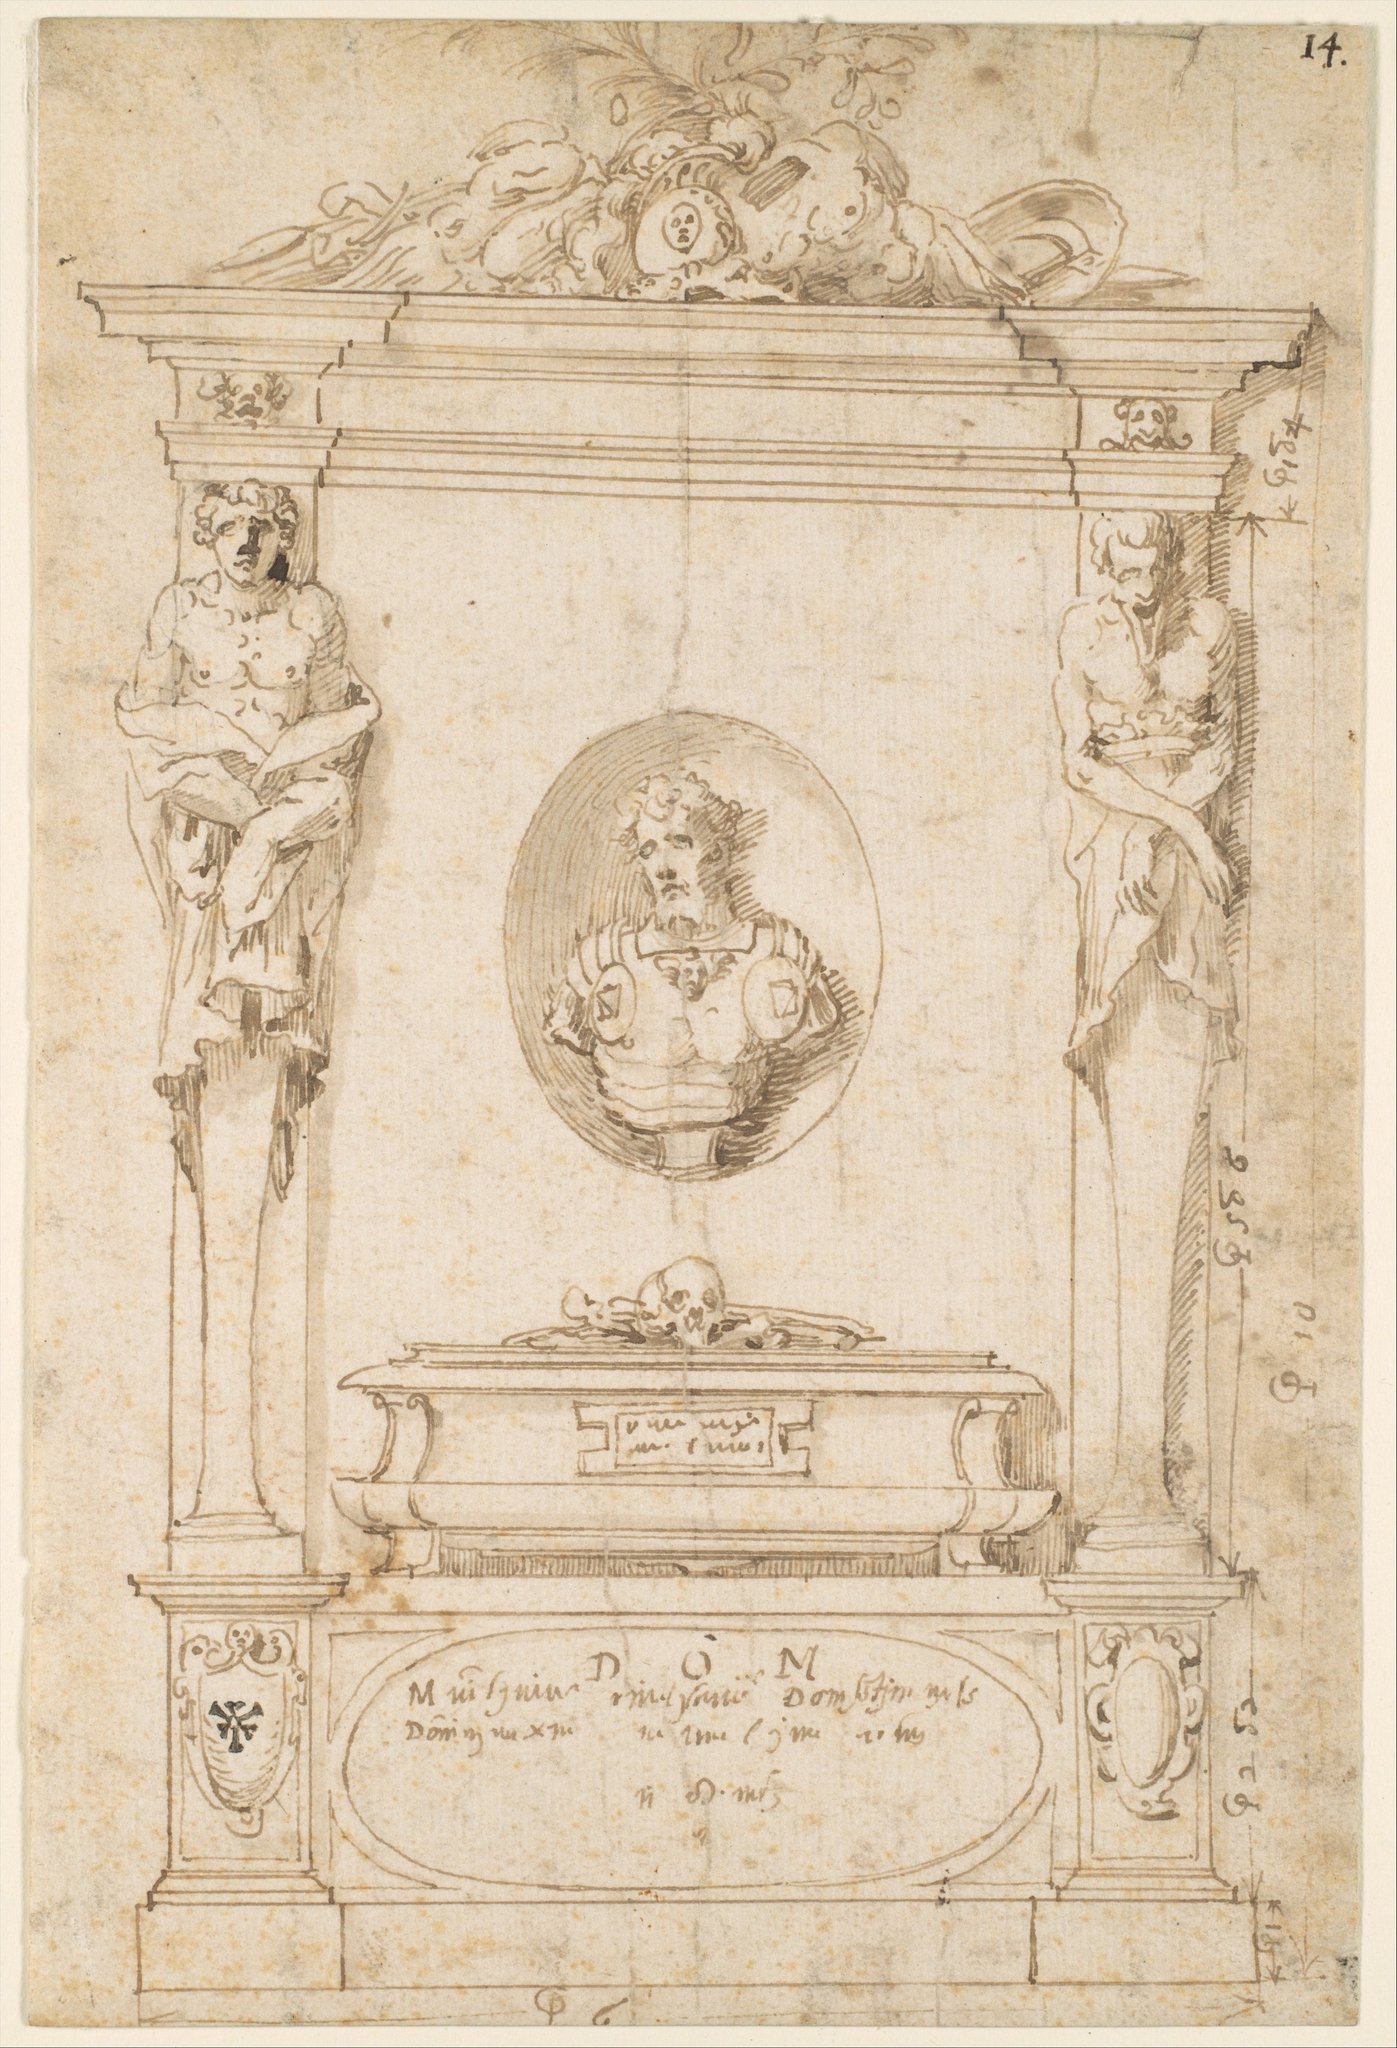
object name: drawing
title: Design for a Tomb with Herms and a Niche with a Bust Portrait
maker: anonymous, italian, 16th century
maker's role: artist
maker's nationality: italian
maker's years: 1550-1600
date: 1501-1600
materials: ink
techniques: brush, pen, wash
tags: architecture,tombs,men,portraits